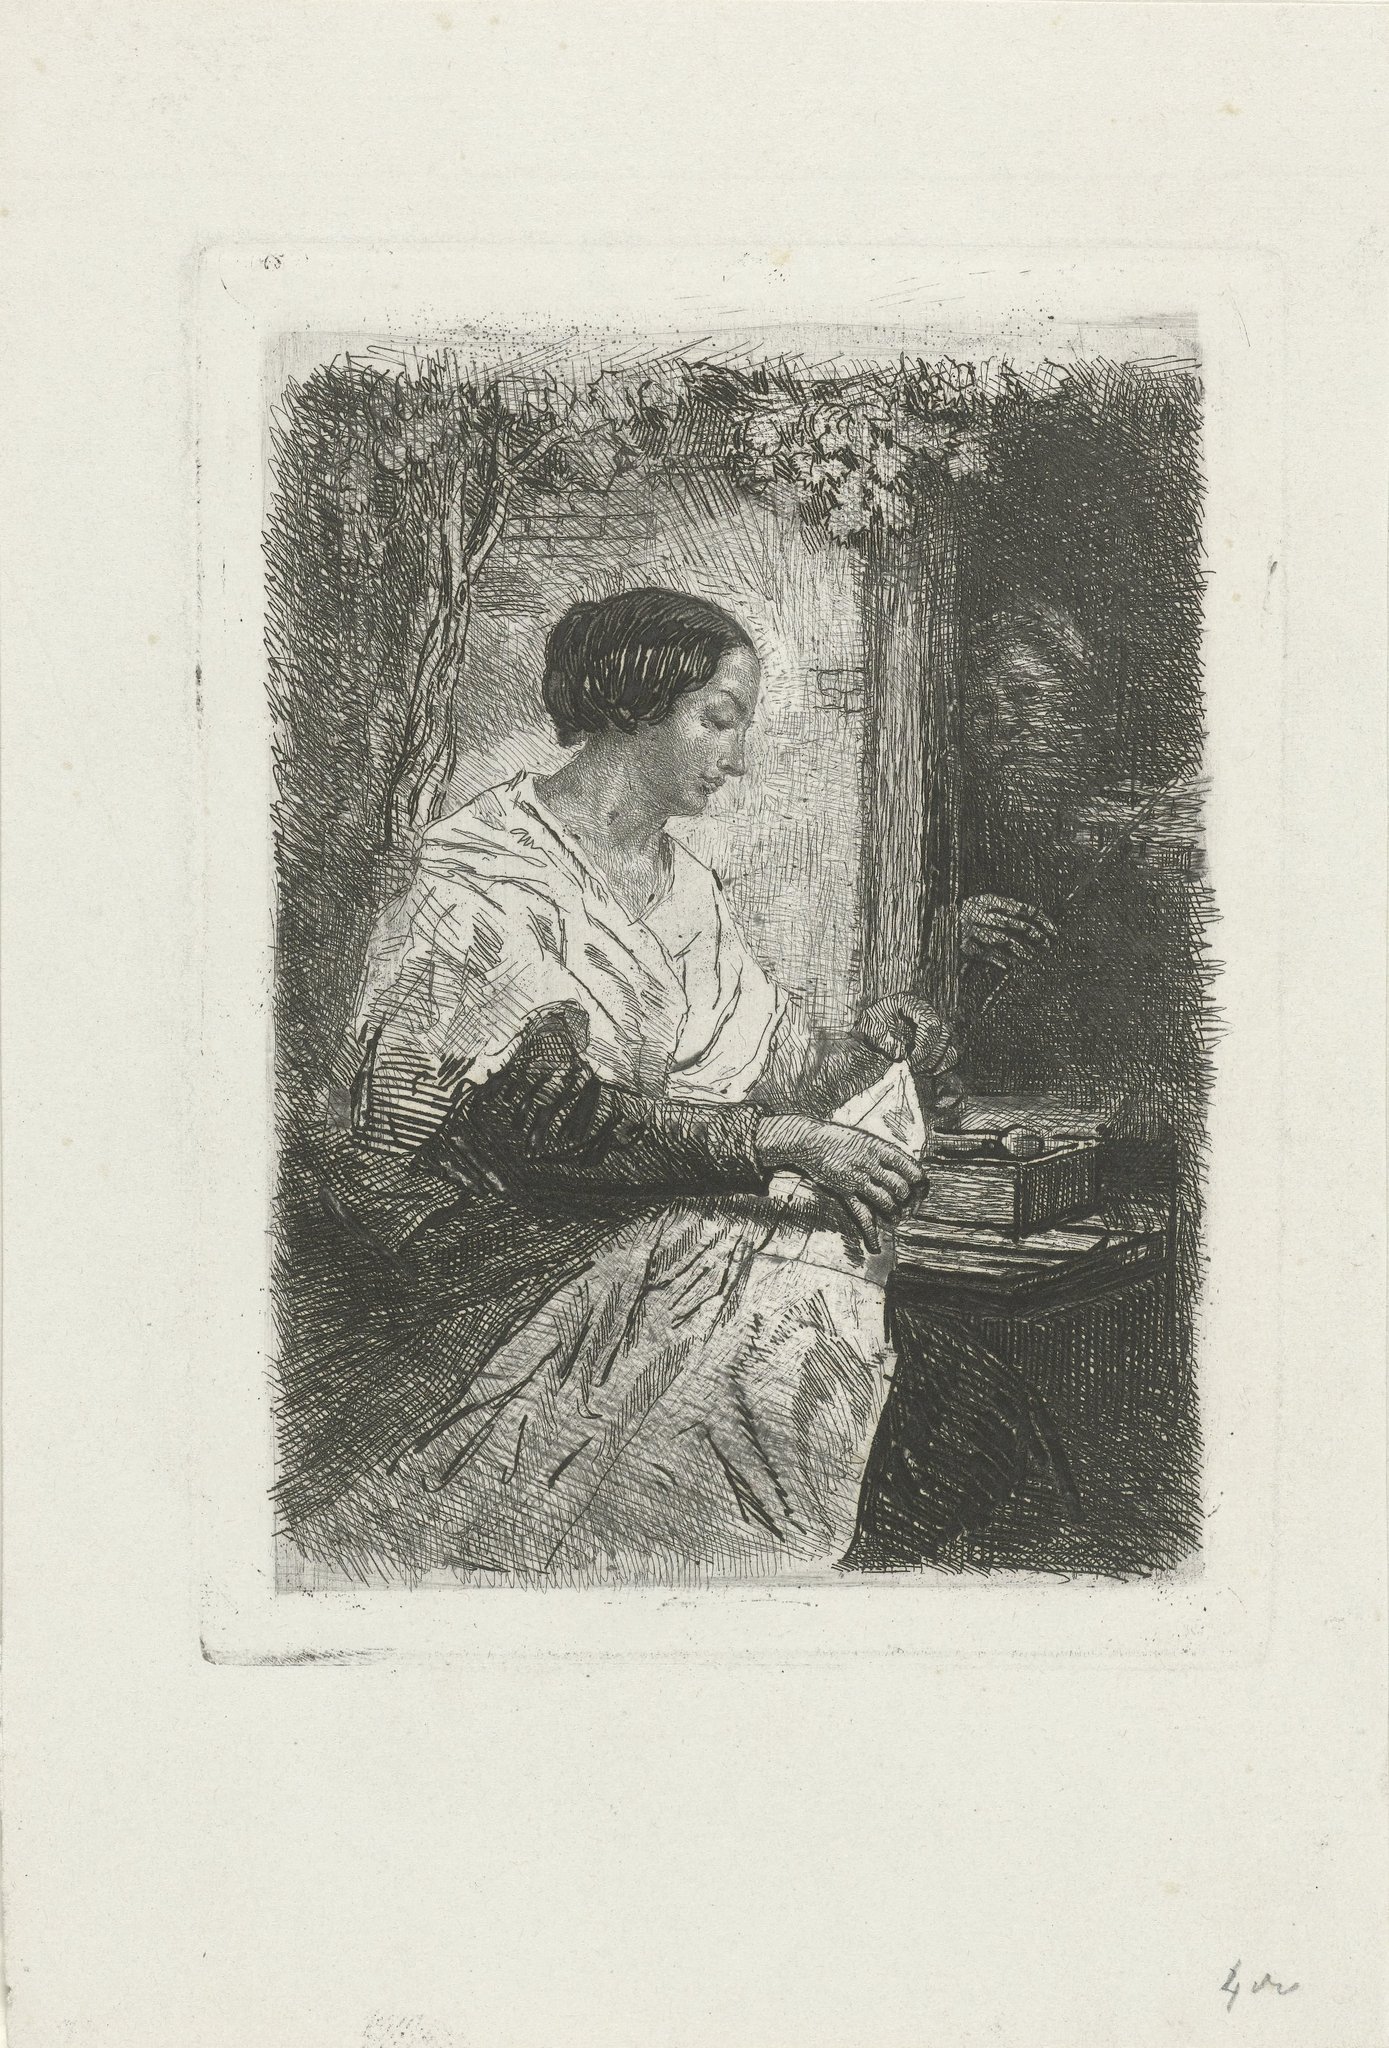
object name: print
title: Naaister en vioolspeler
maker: reinier craeyvanger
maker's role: draughtsman, print maker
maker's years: 1812-1880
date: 1822-1880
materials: paper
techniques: etching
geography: amsterdam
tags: one person playing string instrument (bowed), violin, fiddle, home sewing; repair of clothes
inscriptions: collector's mark: Lugt 2228, collector's mark: Lugt 2166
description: Een vrouw zit op een bankje en gebruikt naald en draad om een laken te verstellen. In de deuropening achter haar speelt een oude man viool.